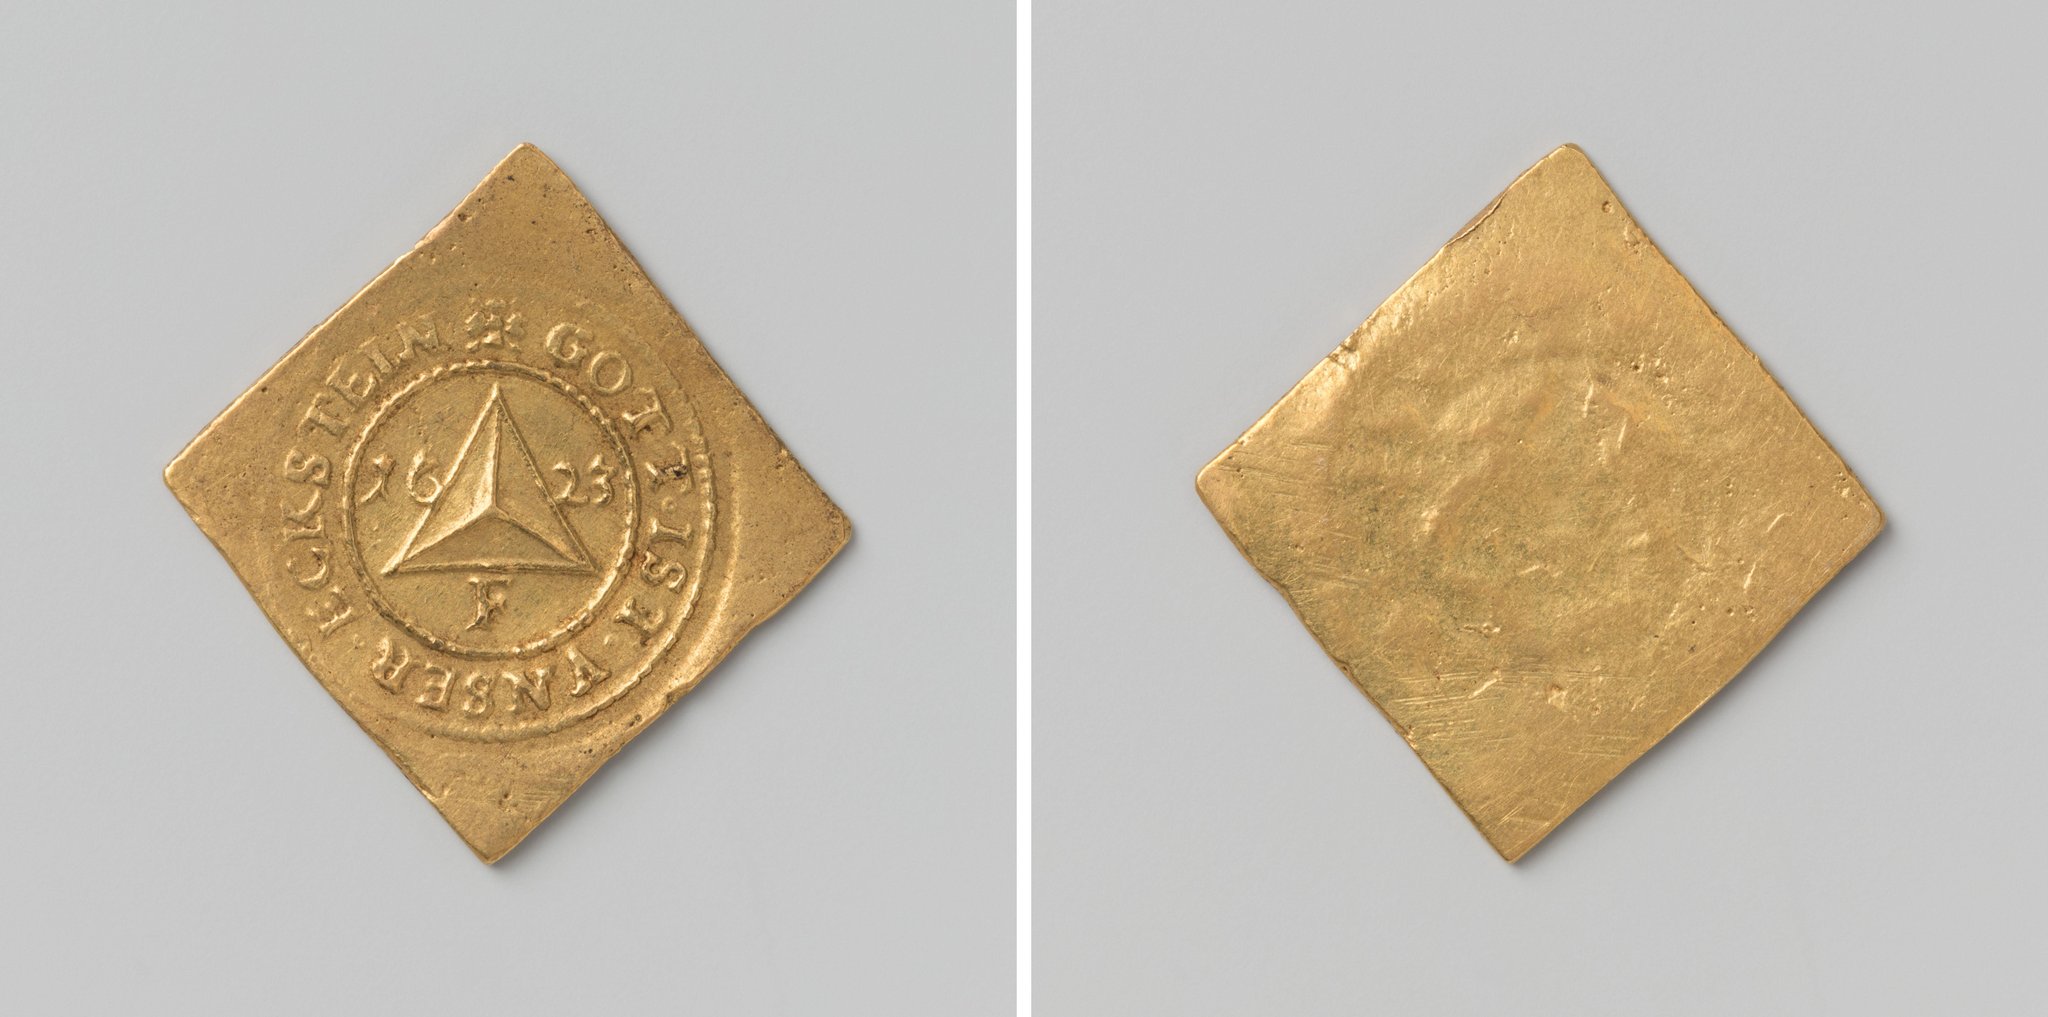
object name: siege coin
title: gouden dukaat, noodmunt uit Frankenthal, geslagen tijdens het beleg door Verdugo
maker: Anonymous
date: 1623-1883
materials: gold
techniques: striking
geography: frankenthal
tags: frankenthal, beleg van frankenthal (1623)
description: eenzijdige, ruitvormige noodmunt. Voorzijde: een stempel: hoeksteen tussen jaartal boven letter F binnen parelrand en omschrift. Keerzijde: blanco